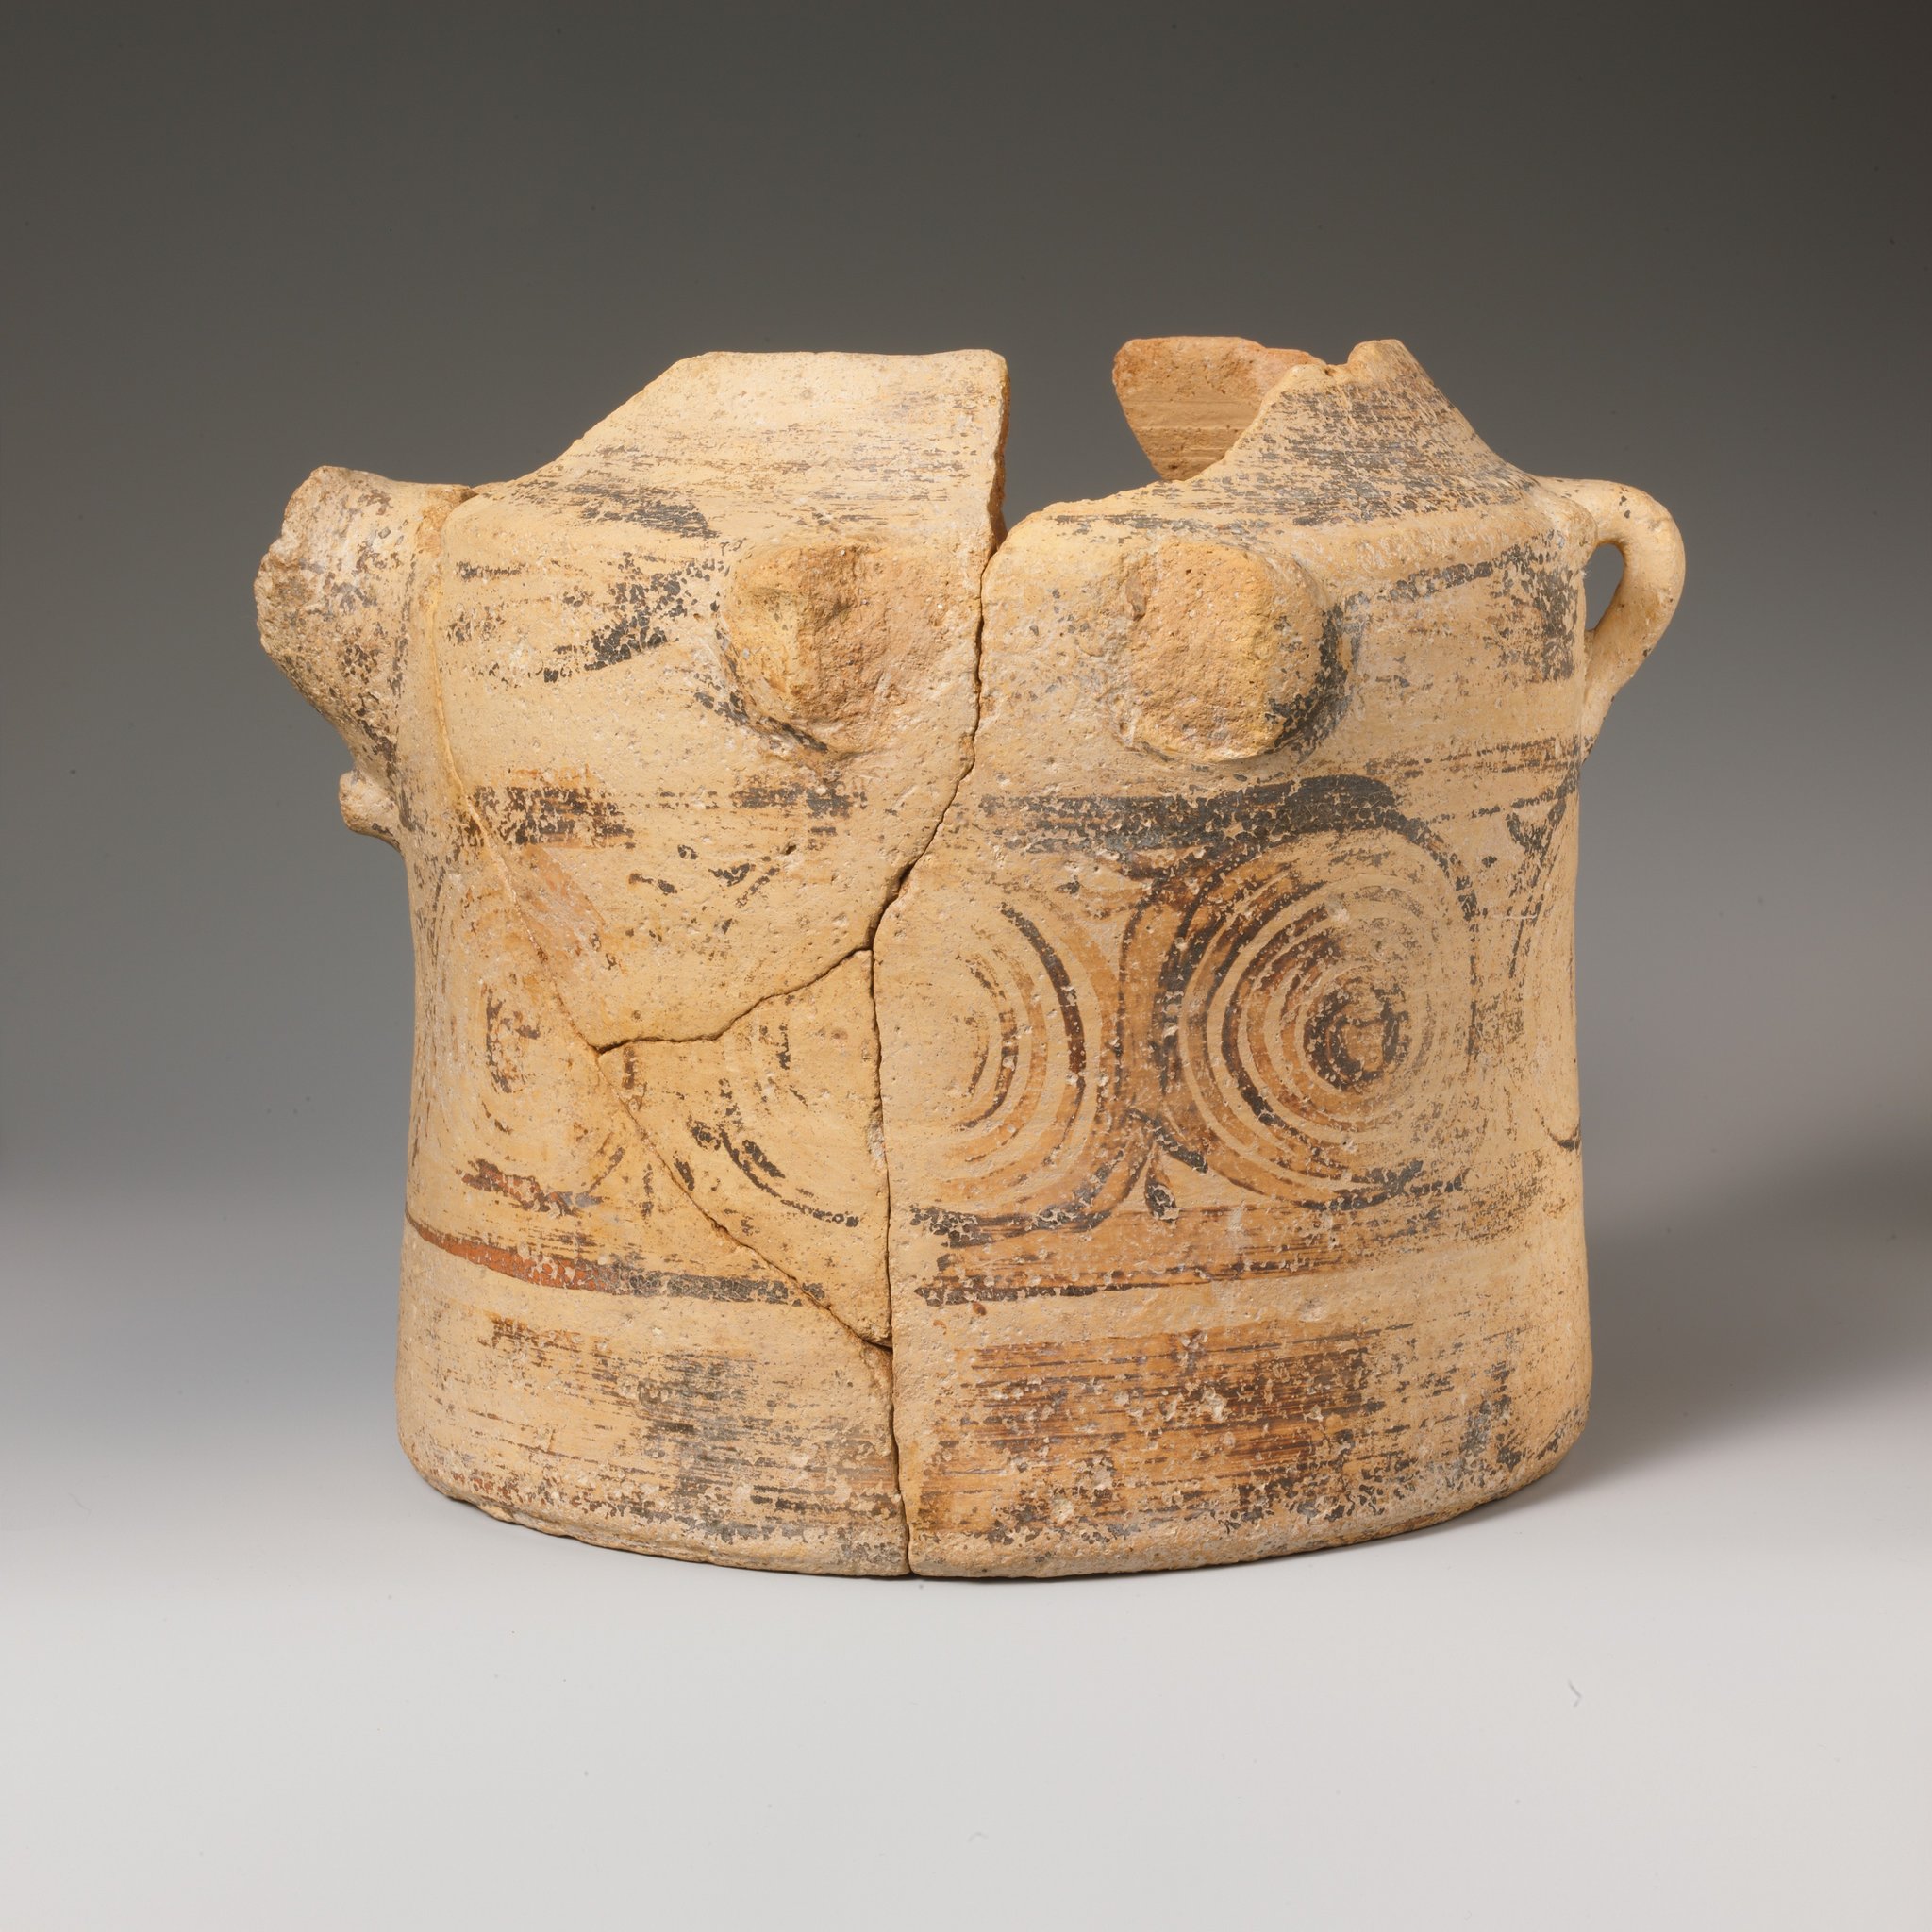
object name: jar, cylindrical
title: Terracotta bridge-spouted jar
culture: minoan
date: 1600-1450 BCE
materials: terracotta